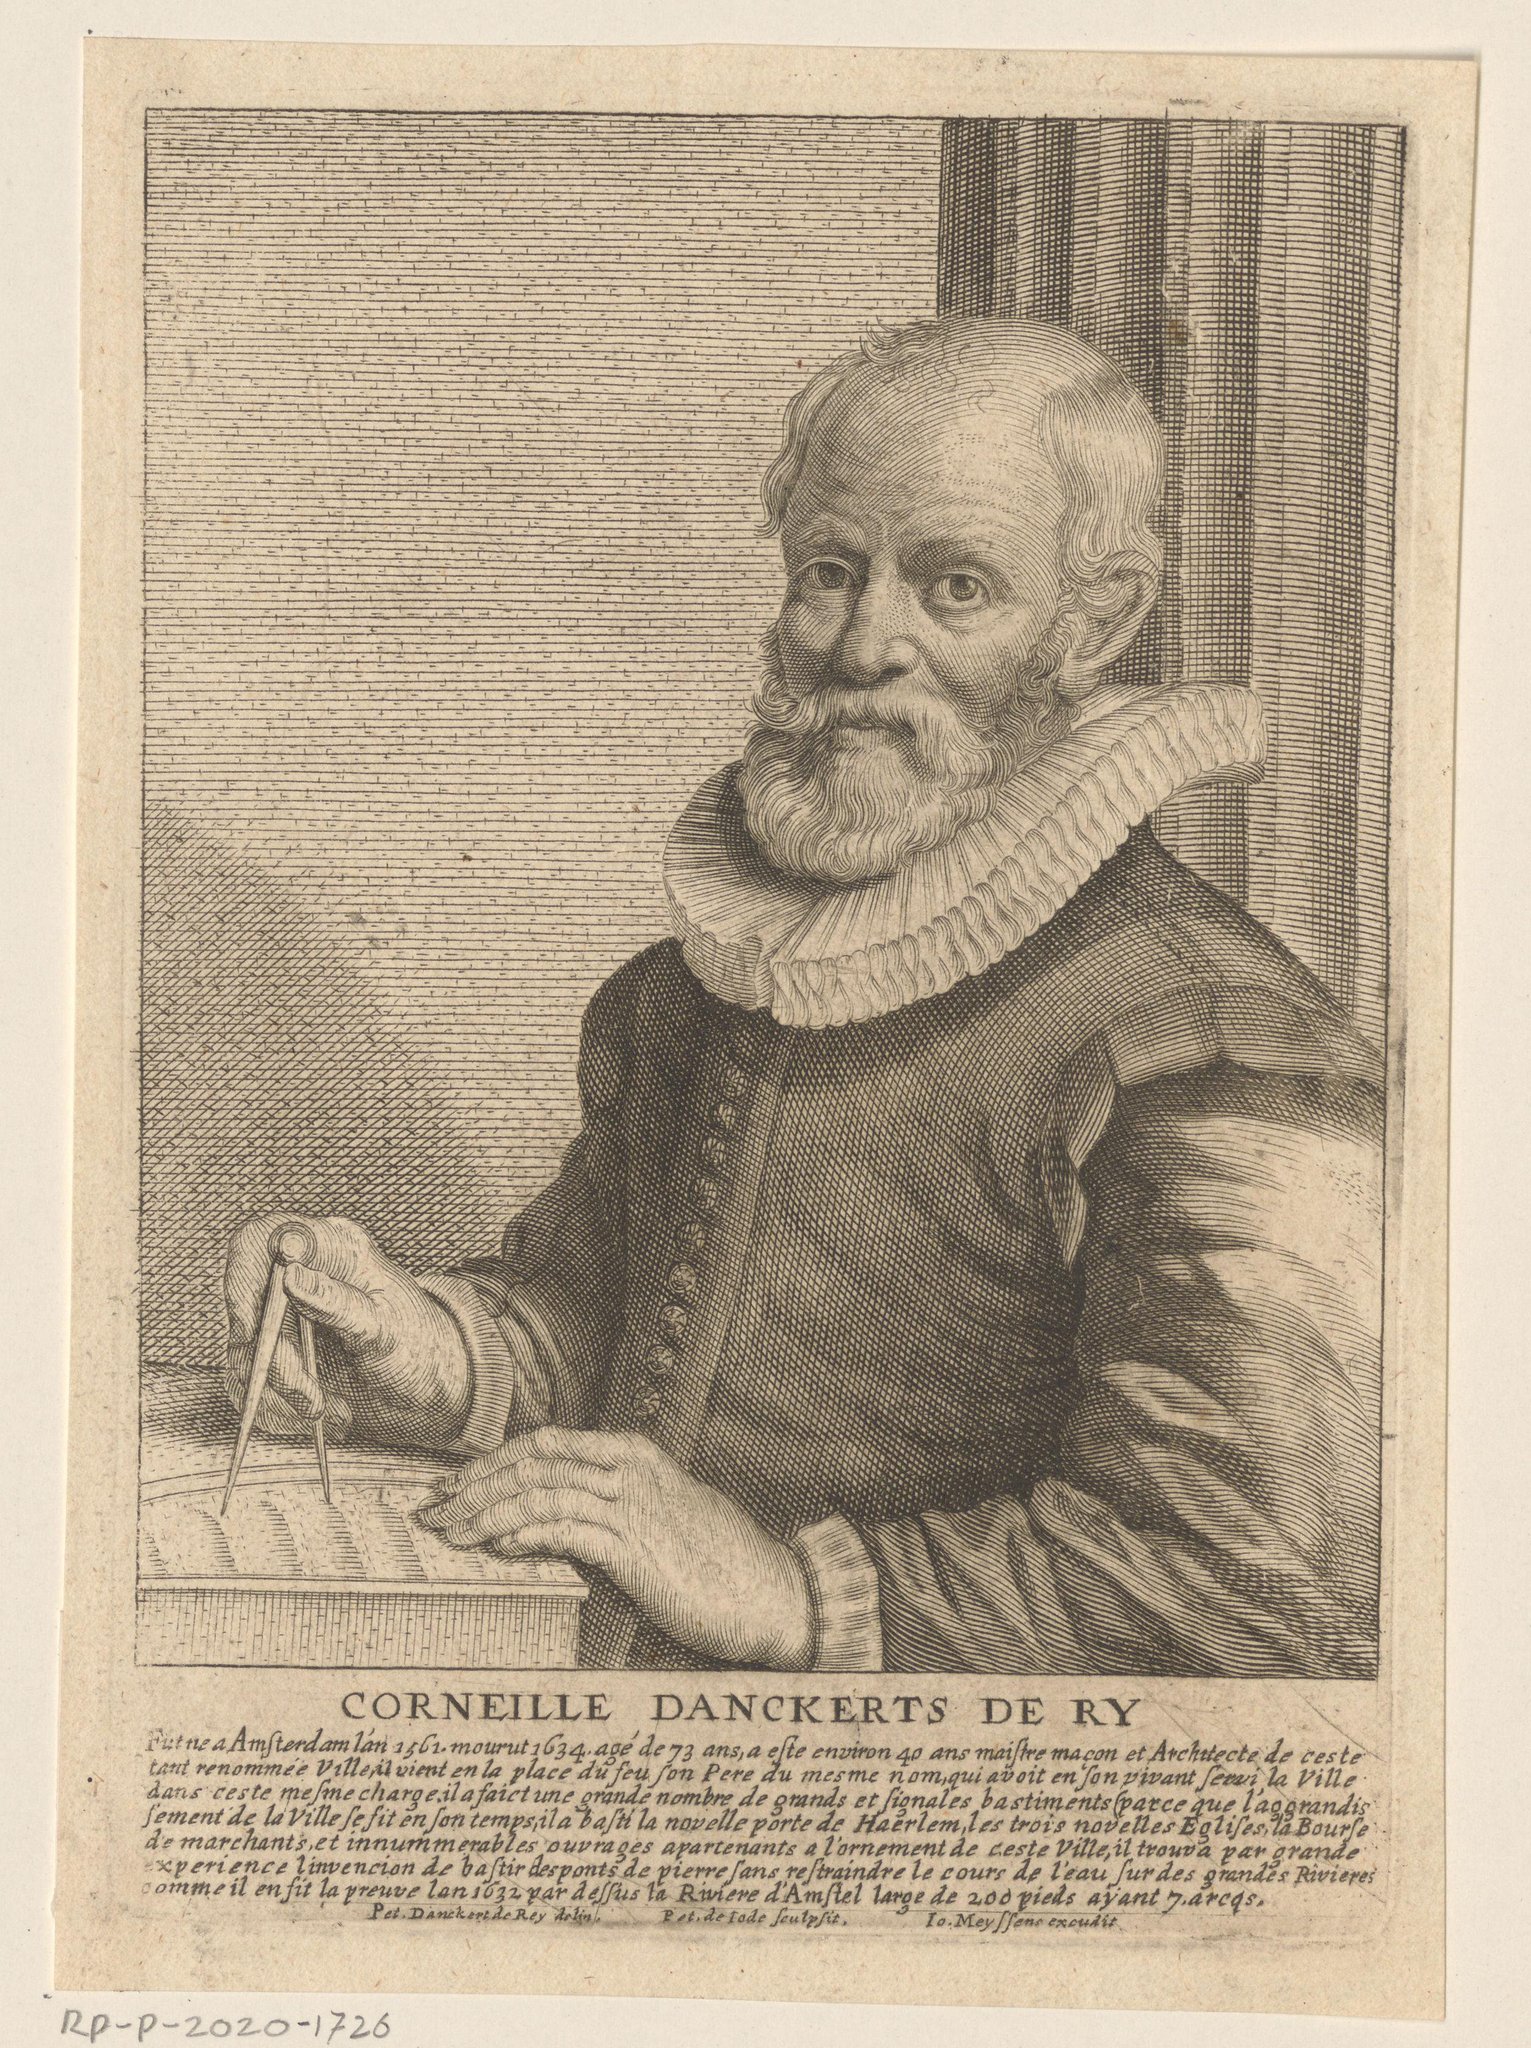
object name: print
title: Portret van Cornelis Danckerts de Ry op 73-jarige leeftijd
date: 1634-1674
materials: paper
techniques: engraving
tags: historical persons, compasses, portrait, self-portrait of architect